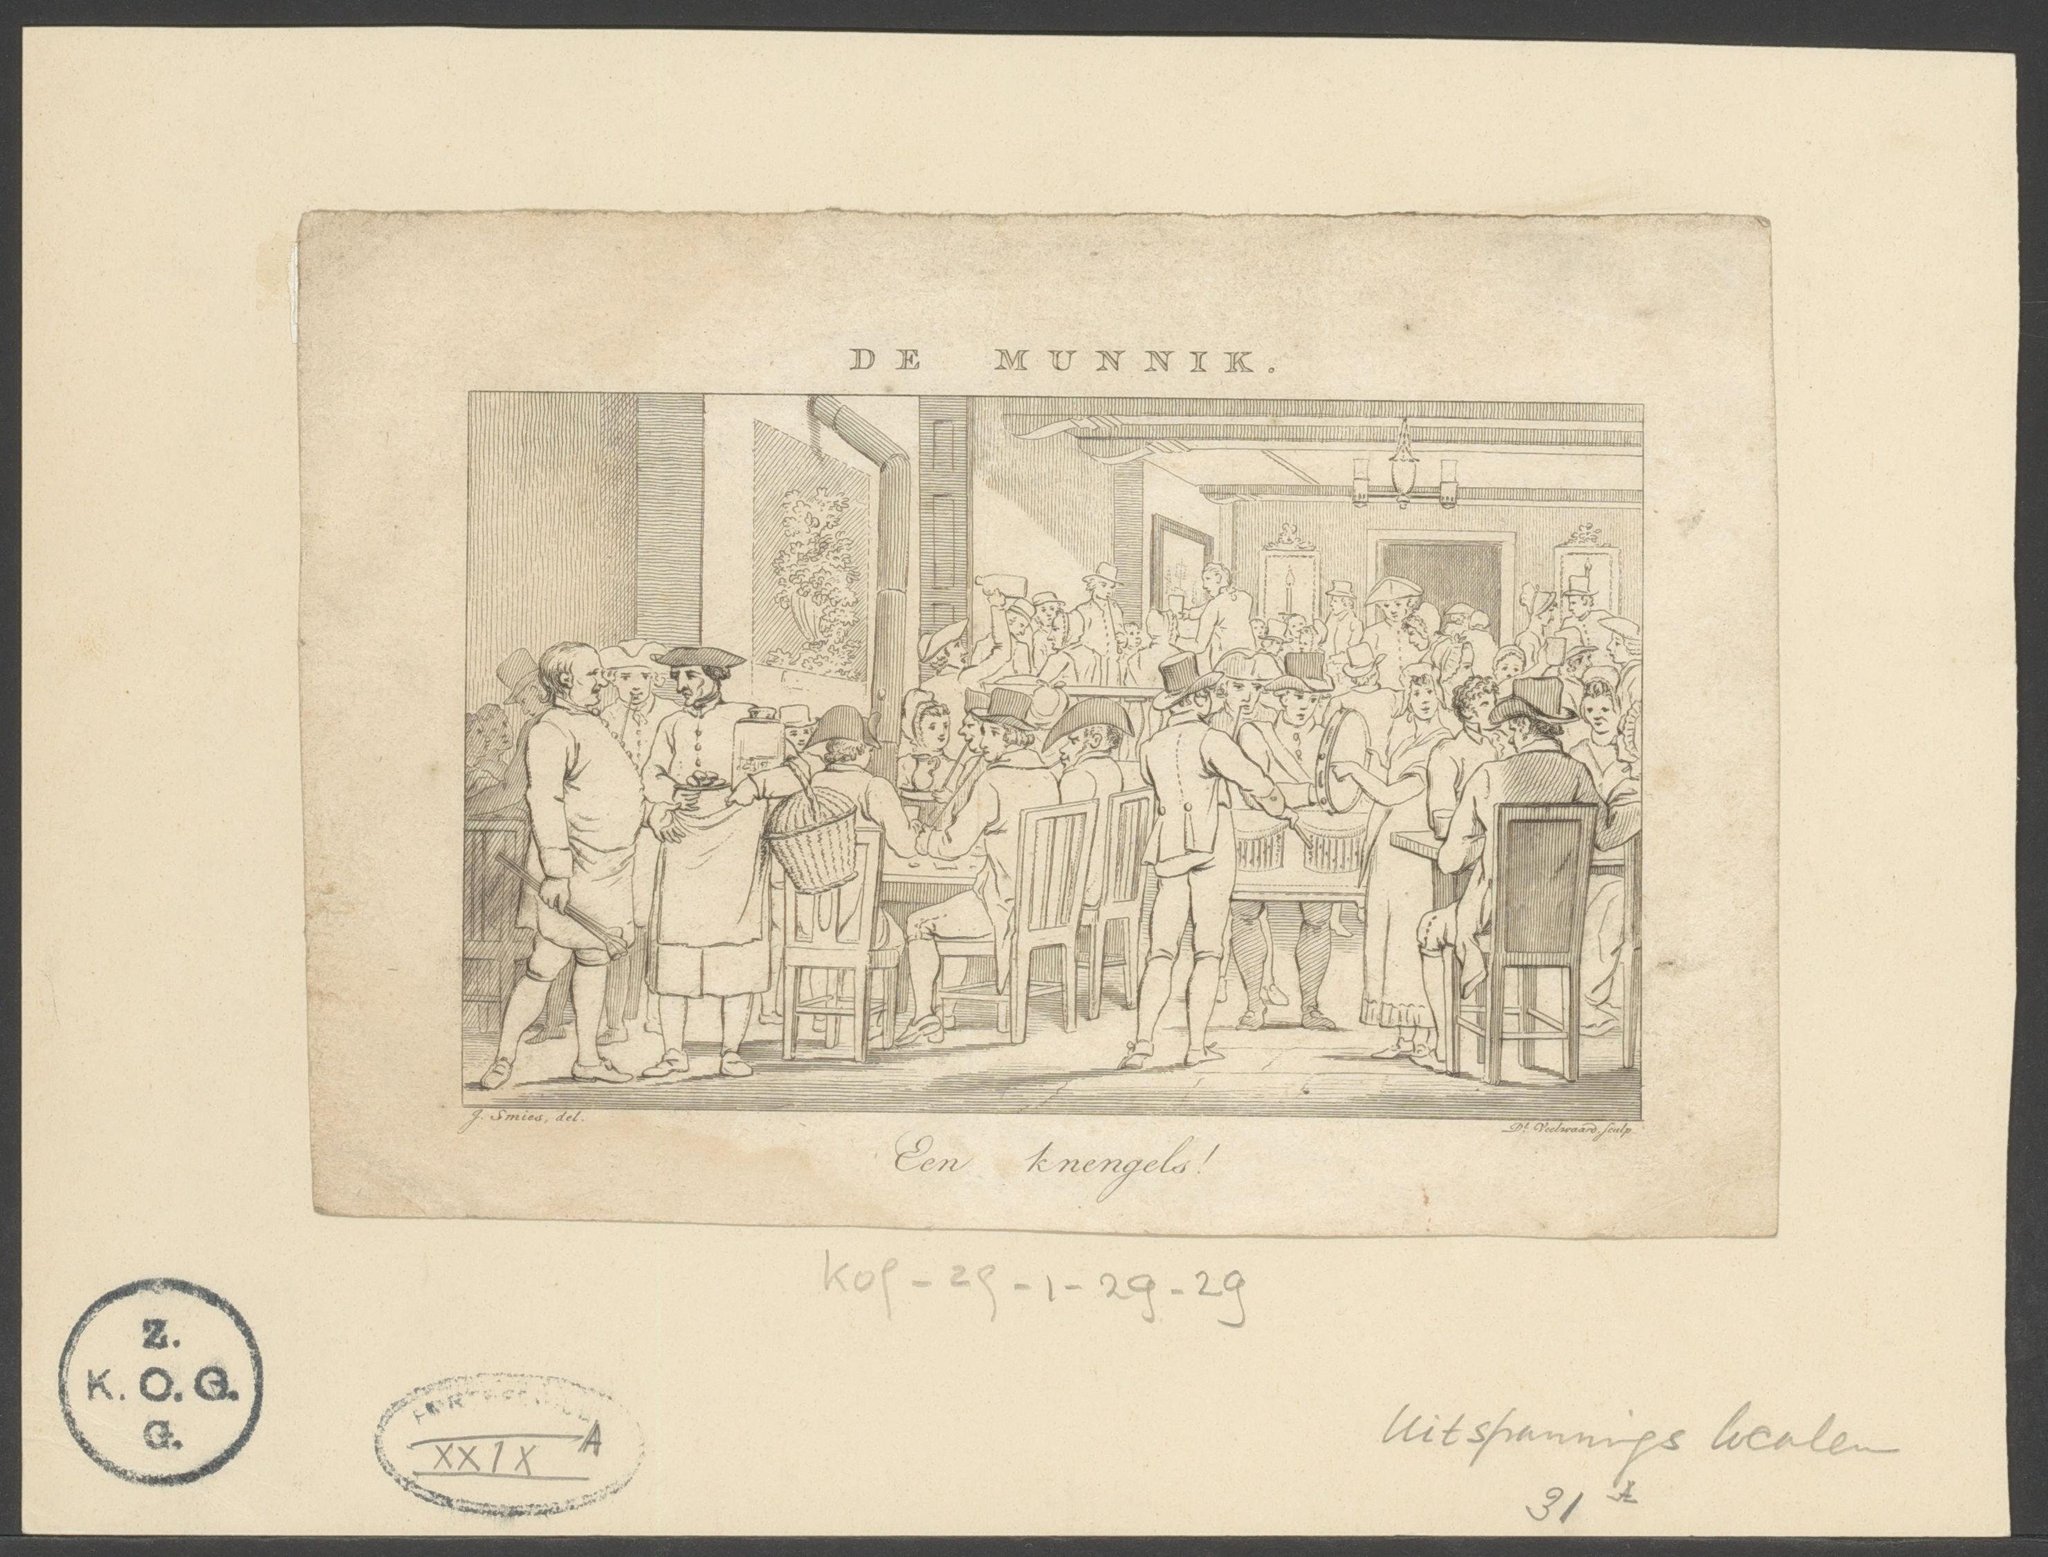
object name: print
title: Interieur van De Munnik in Amsterdam, 1808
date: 1808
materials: paper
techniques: etching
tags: inn, coffee-house, public house, etc.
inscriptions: collector's mark: Lugt 1641, stamp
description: Vele figuren in het interieur van de herberg De Munnik op de hoek van de Monnikenstraat en de Oudezijds Achterburgwal in Amsterdam, 1808. Onderwerpsrubrieken binnen de Atlas Zeden en Gewoonten: Zeden en gewoonten in engeren zin, Volksleven, Uitspanningslokalen, Koffiehuizen.